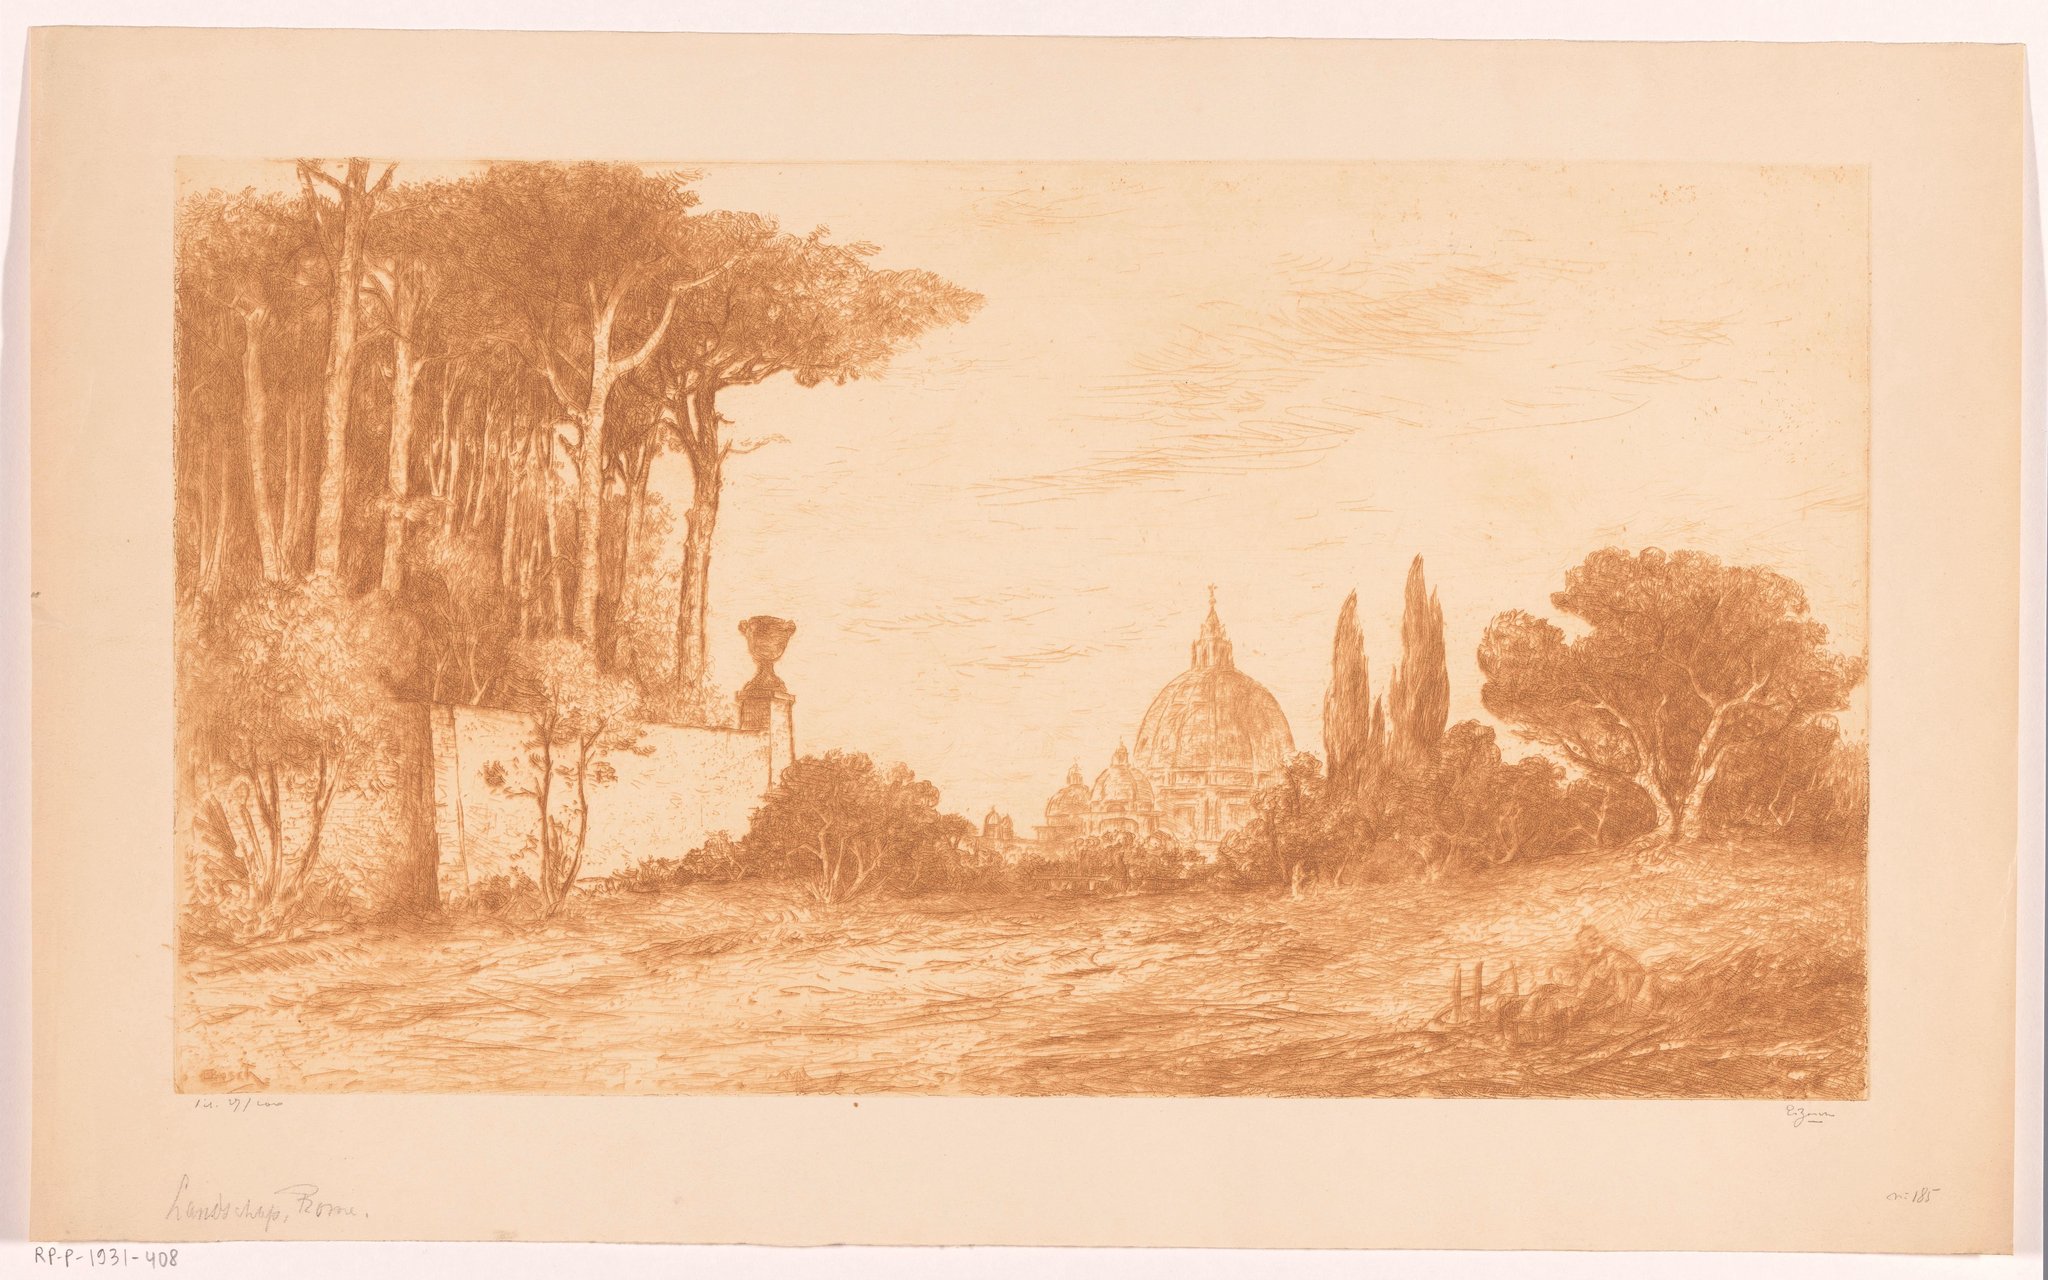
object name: print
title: Landschap, Rome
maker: etienne bosch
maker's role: print maker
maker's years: 1863-1933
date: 1873-1931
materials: paper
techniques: etching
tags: city-view, and landscape with man-made constructions, low hill country, parts of church exterior and annexes: dome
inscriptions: number: ‘no. 185’, collector's mark: Lugt 2228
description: Zicht op de koepels van de Sint-Pietersbasiliek vanaf een gedeeltelijk met bomen begroeide heuvel. Rechts op de voorgrond een knielende figuur.